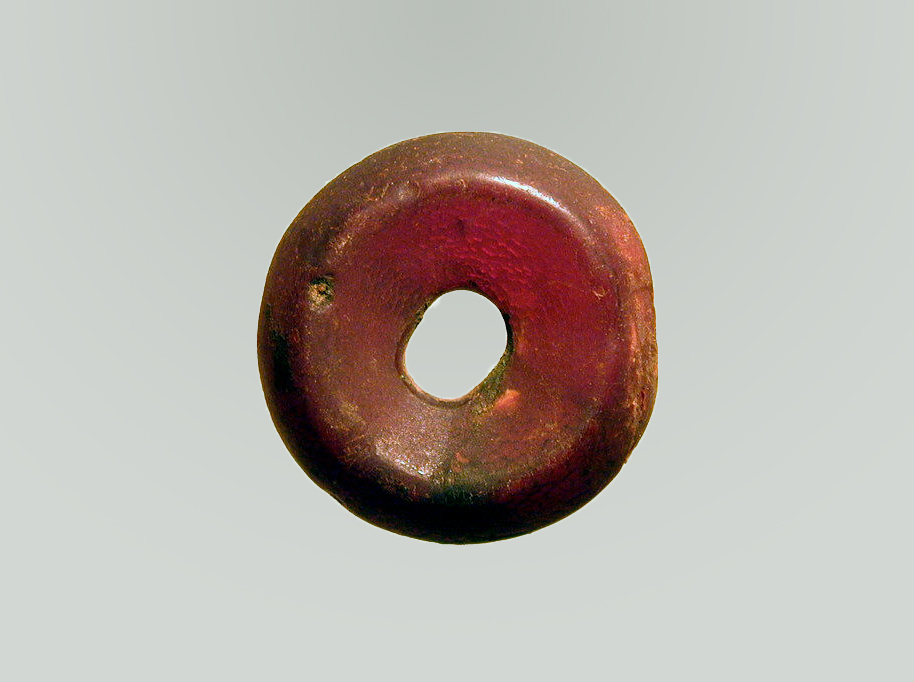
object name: whorl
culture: etruscan or italic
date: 700-601 BCE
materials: amber